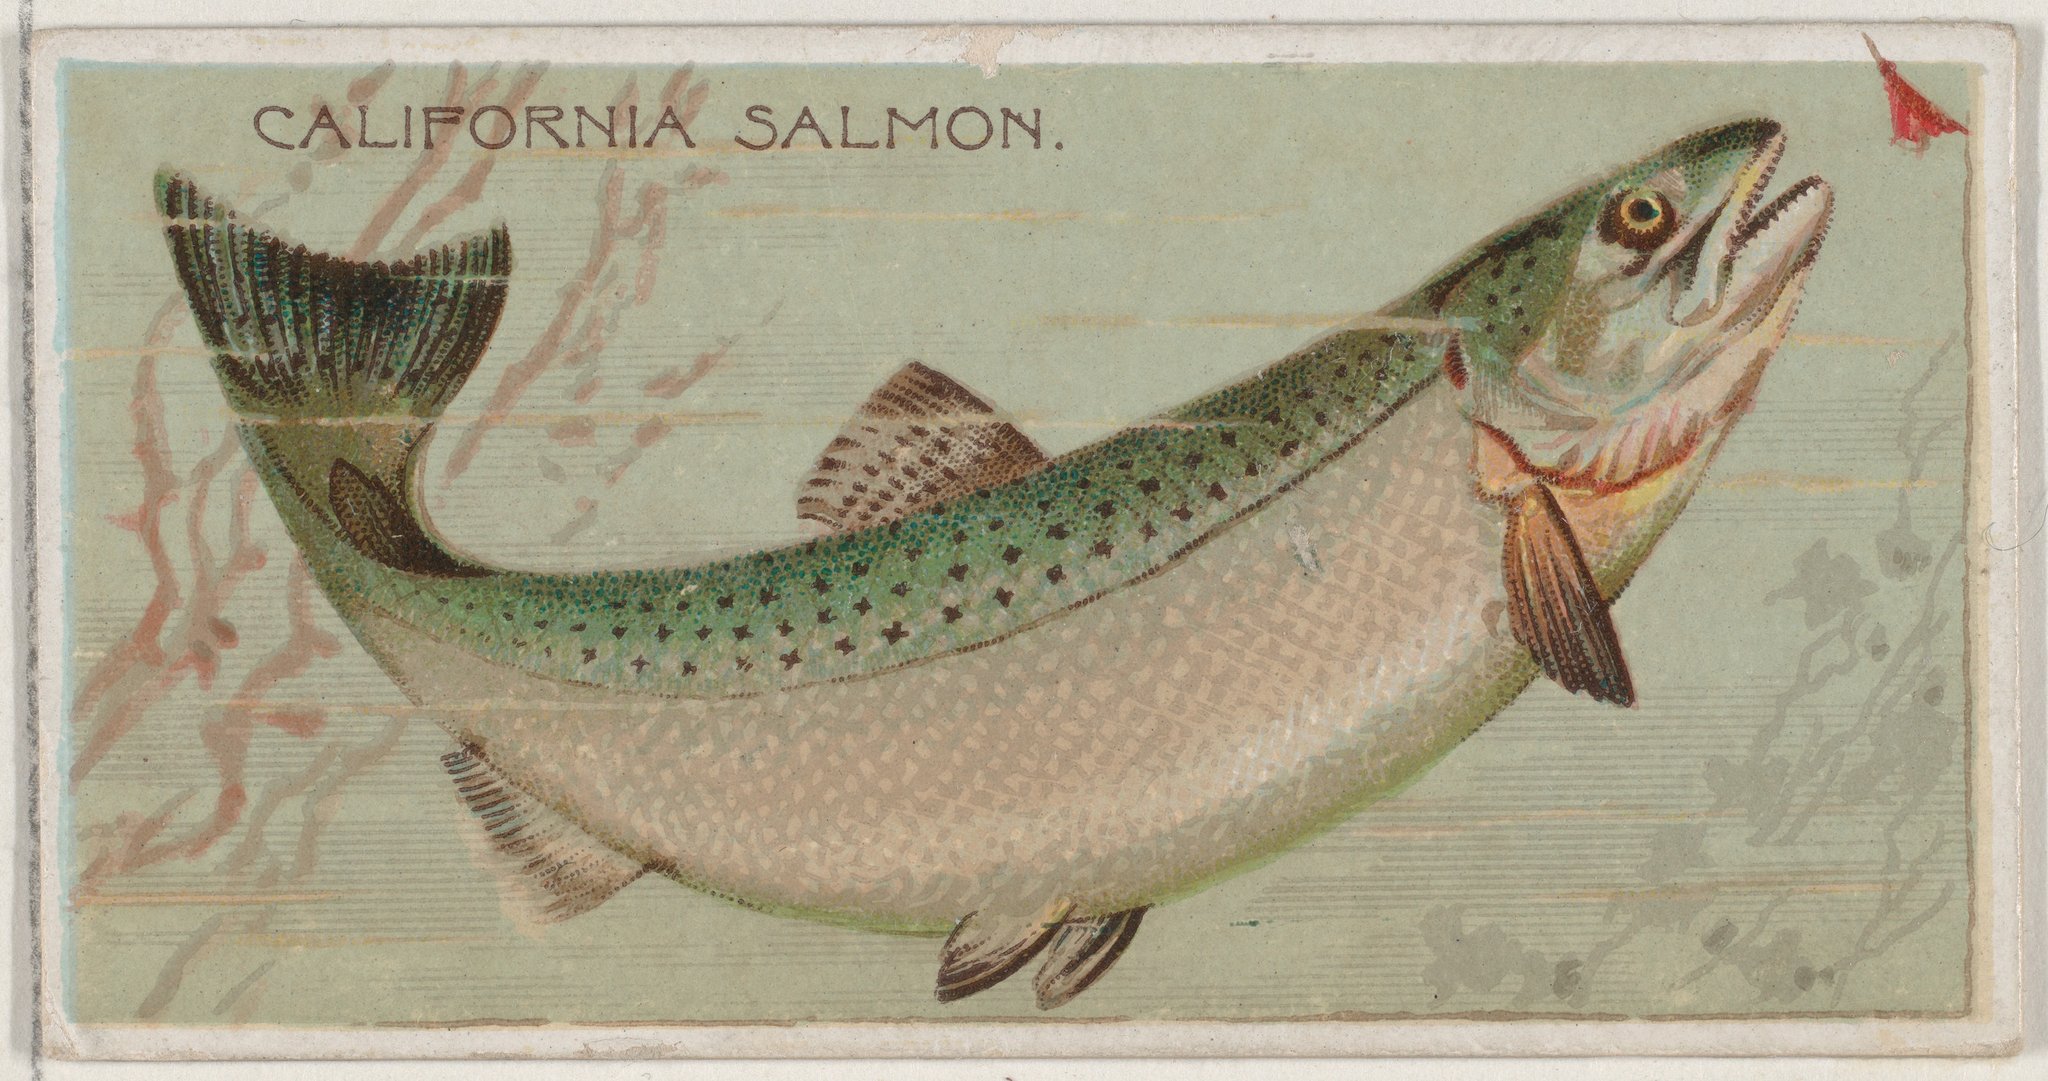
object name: print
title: California Salmon, from the series Fishers and Fish (N74) for Duke brand cigarettes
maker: knapp & company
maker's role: lithographer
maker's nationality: american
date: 1888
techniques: color lithograph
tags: fish